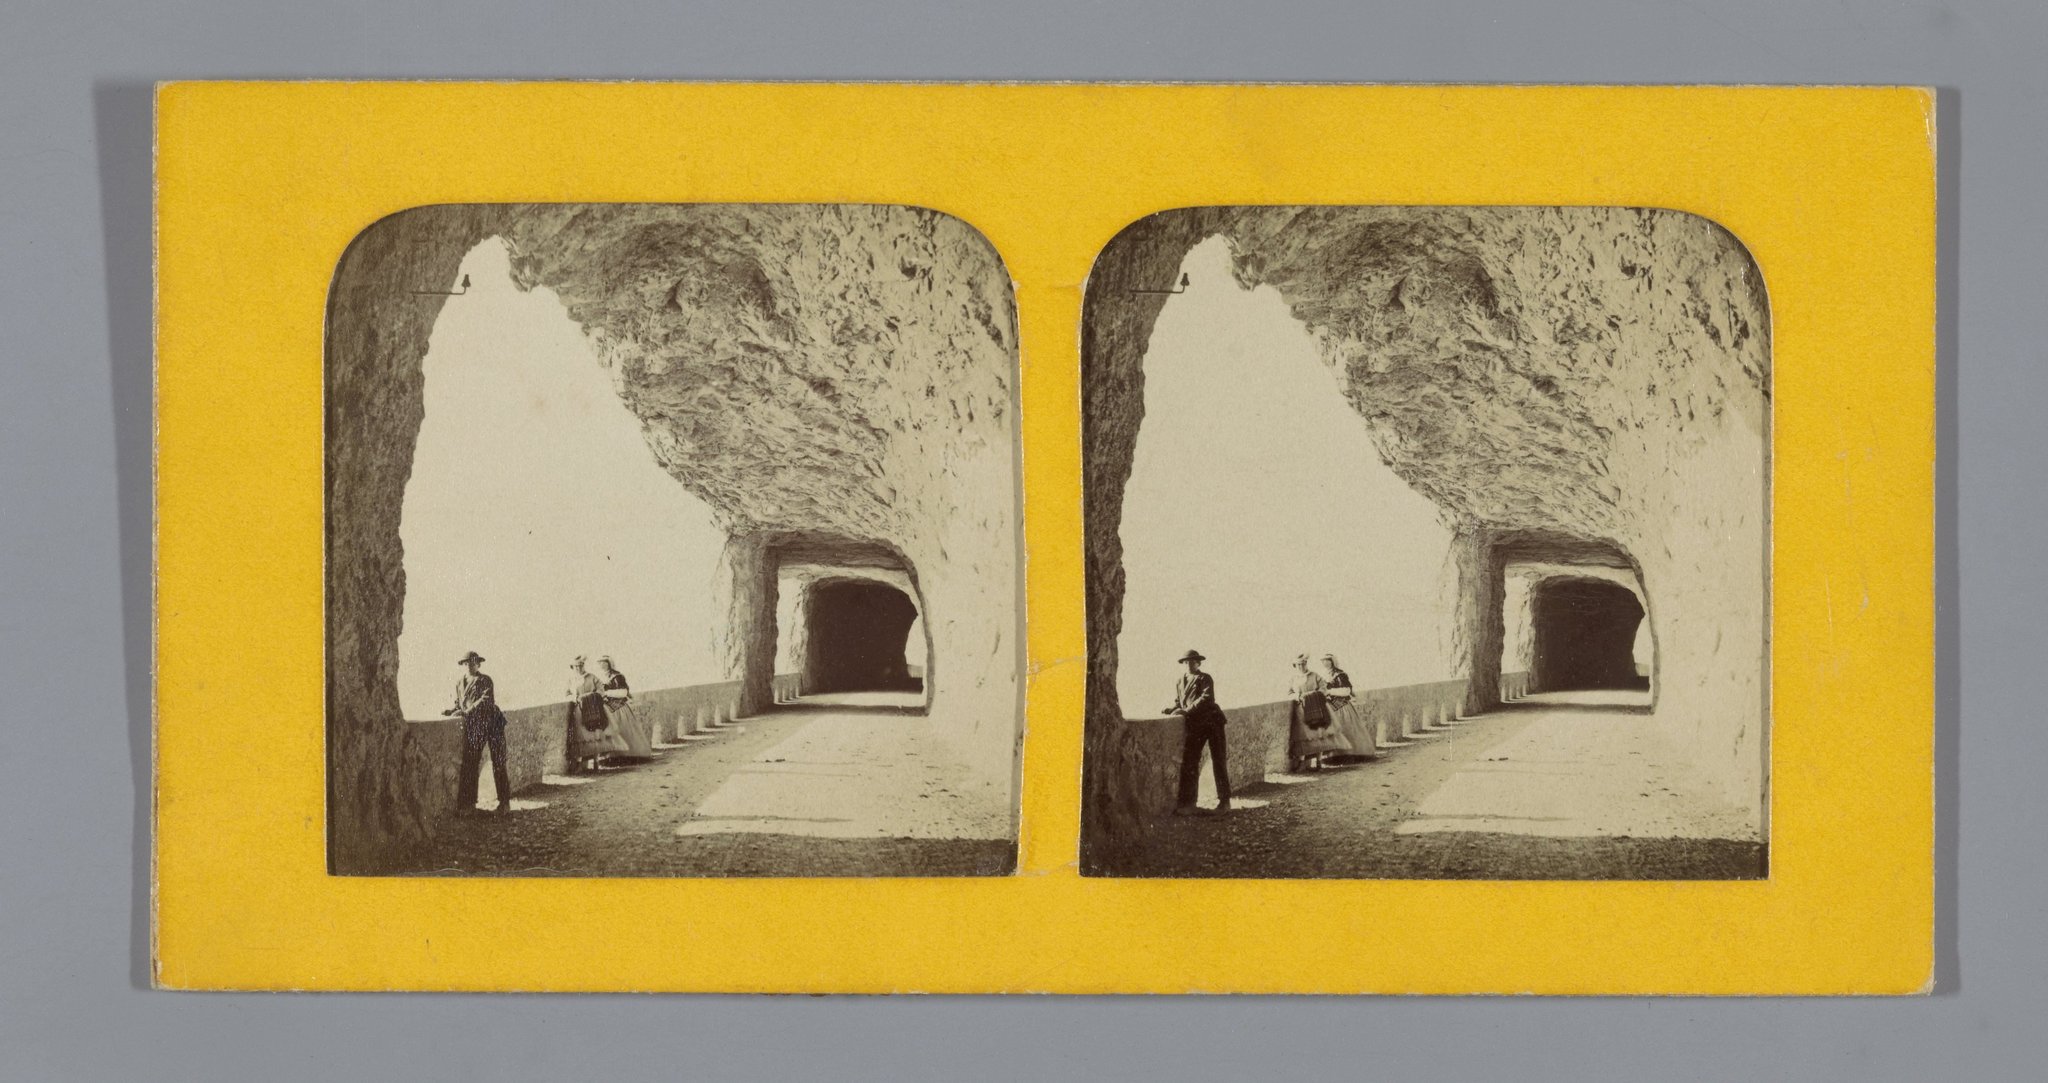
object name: tissue stereograph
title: Galerie de l'exentrane, Suisse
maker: Anonymous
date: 1855-1875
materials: cardboard, paper, photographic support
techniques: albumen print, hand coloring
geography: switzerland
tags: protection against avalanches, road, path, underground road, tunnel, switzerland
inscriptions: inscription: ‘15A’